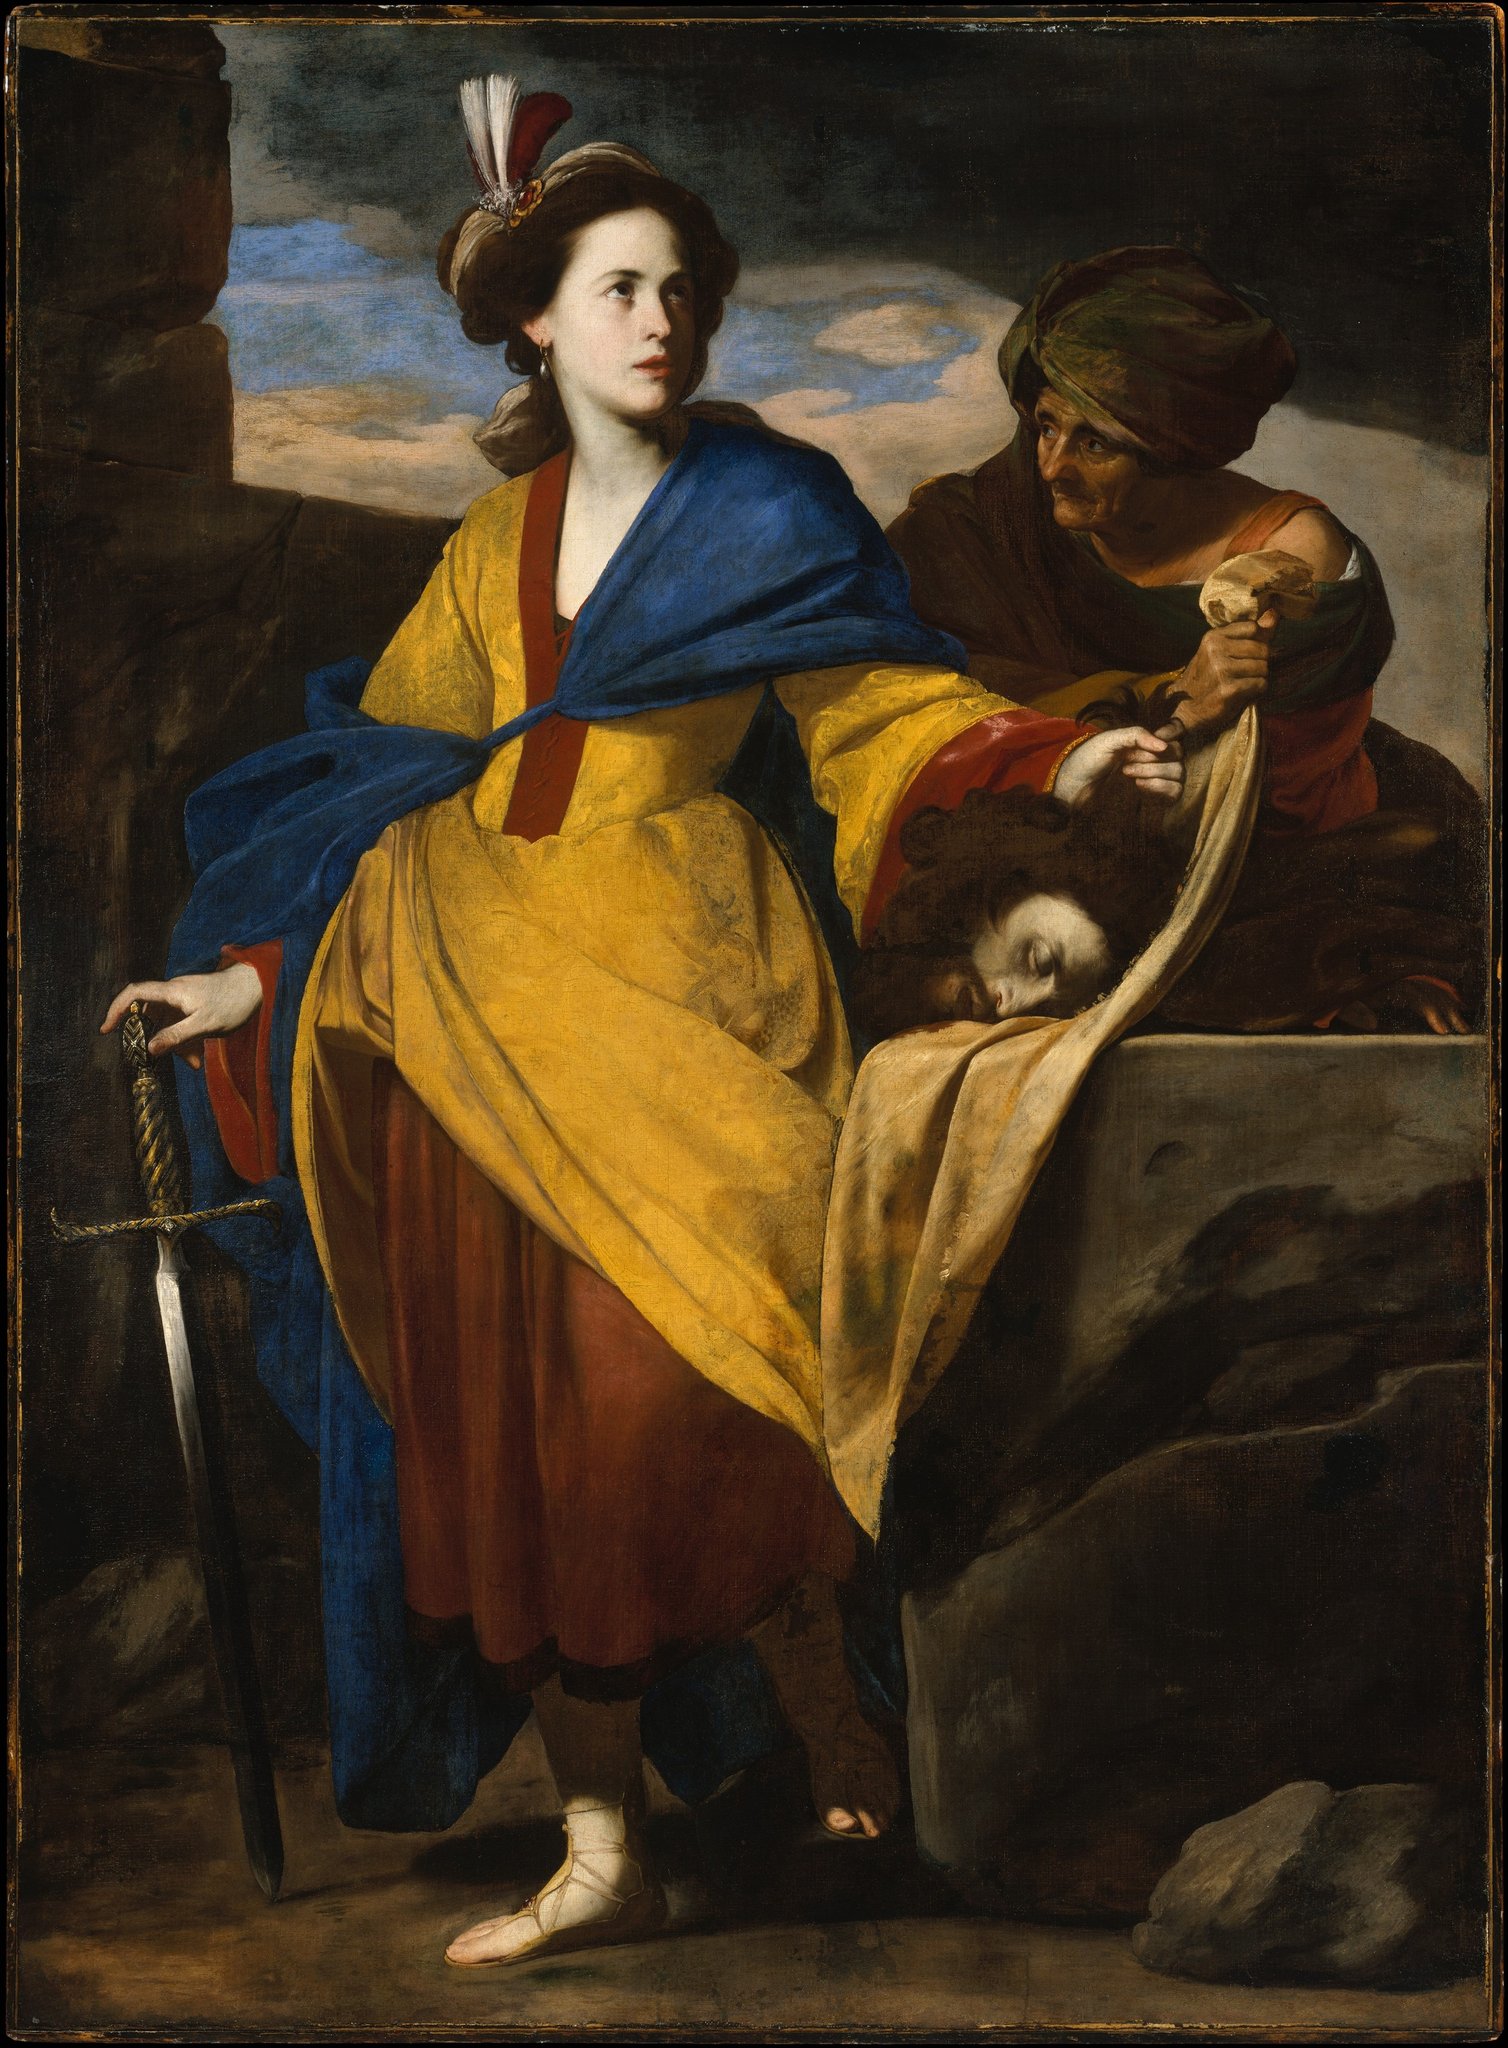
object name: painting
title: Judith with the Head of Holofernes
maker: massimo stanzione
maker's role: artist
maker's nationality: italian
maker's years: 1585-1656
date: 1640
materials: canvas, oil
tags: swords,heads,women,holofernes,judith